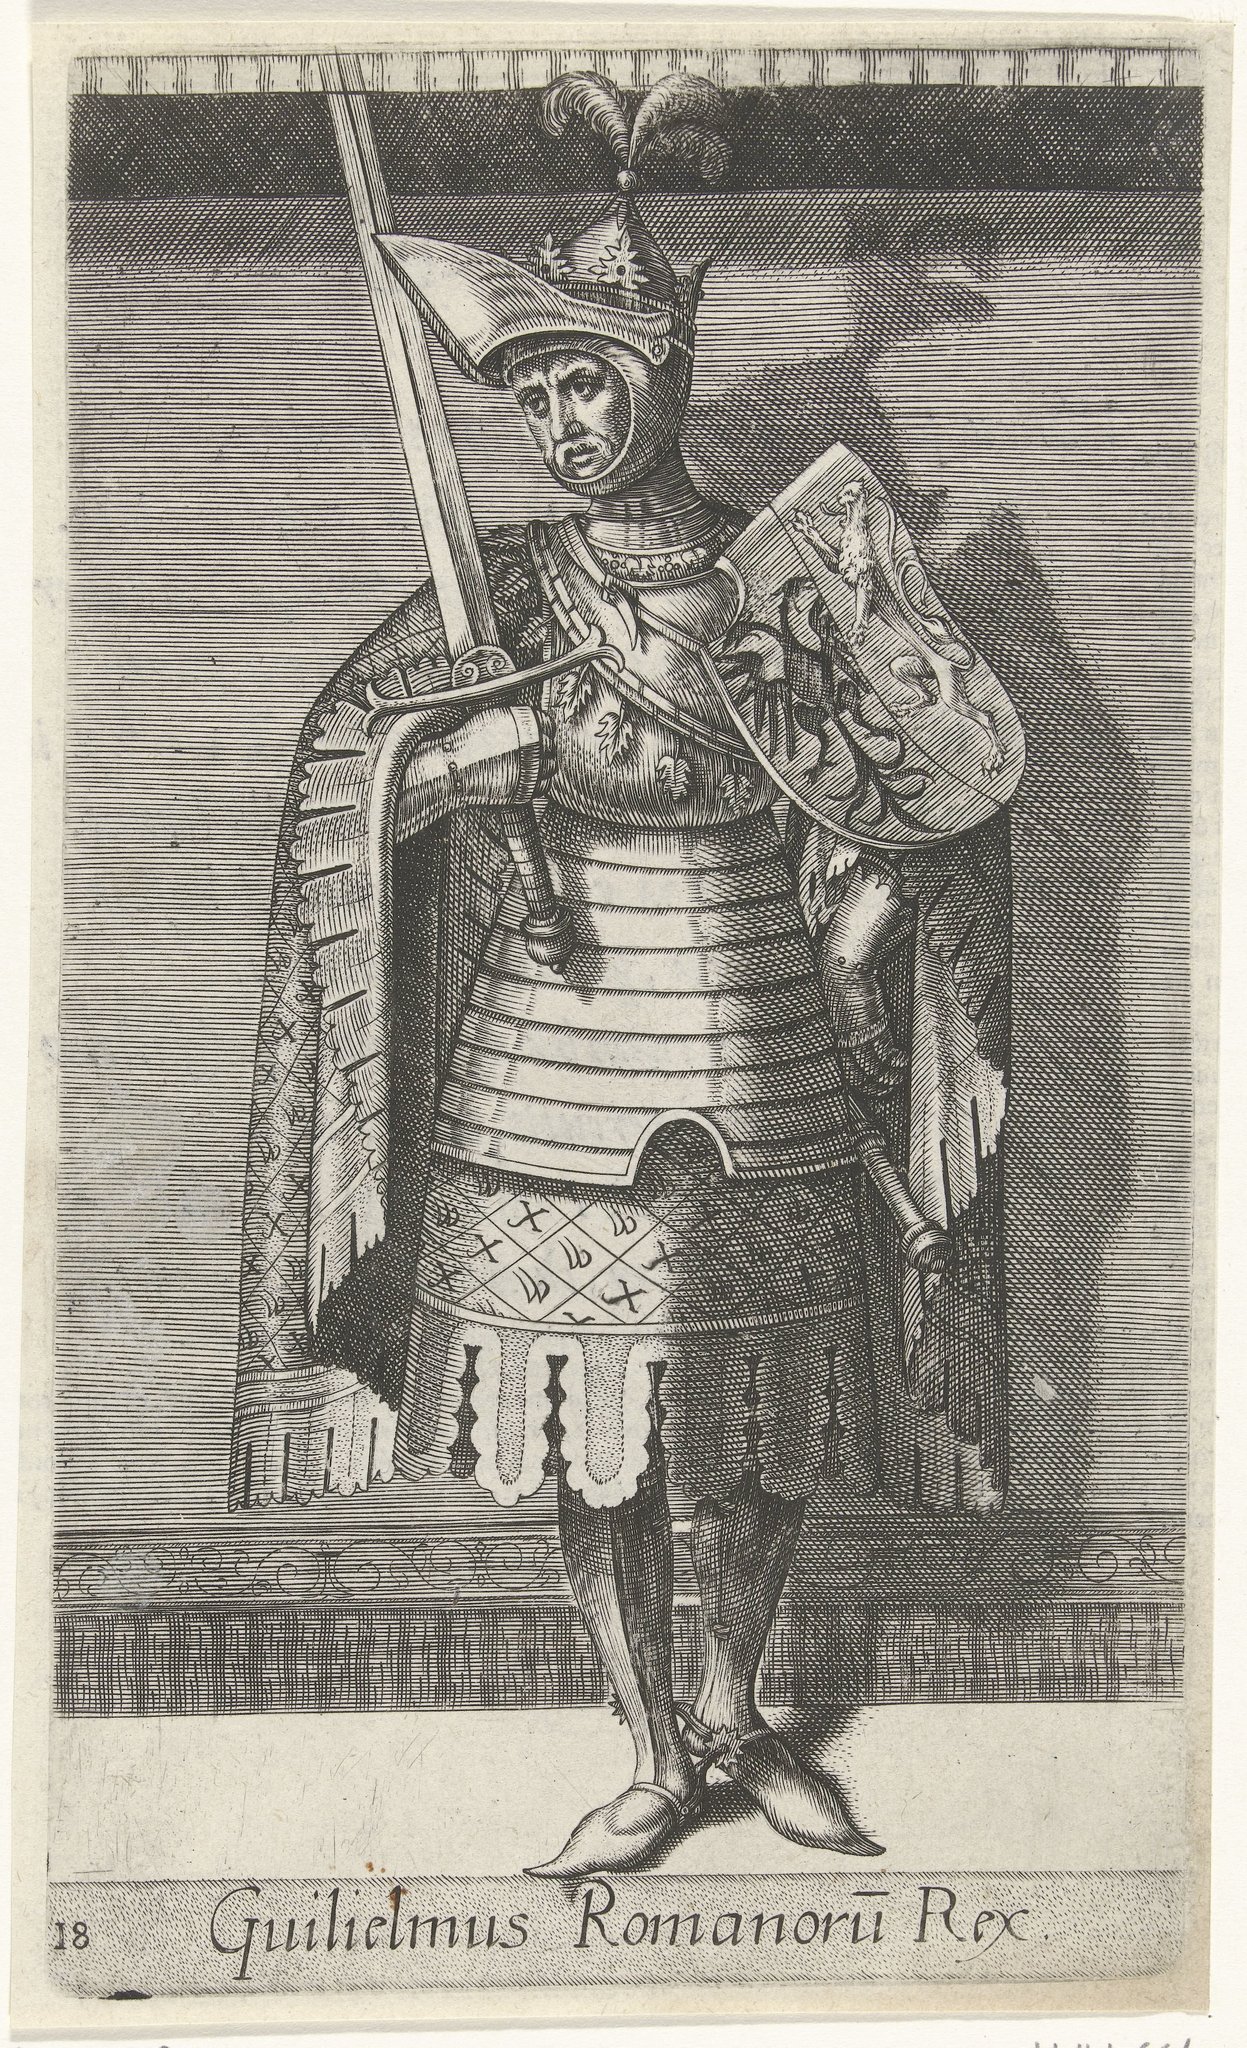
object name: print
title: Guilielmus Romanoru Rex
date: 1578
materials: paper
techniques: engraving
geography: antwerp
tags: earl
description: Willem II, graaf van Holland en rooms-koning. Staande, ten voeten uit. Hij draagt een zwaard in zijn rechterhand. Op zijn linkerschouder het wapenschild van Holland en het Heilig Roomse Rijk. De prent dient als een illustratie bij een boek over de geschiedenis van de graven van Holland.